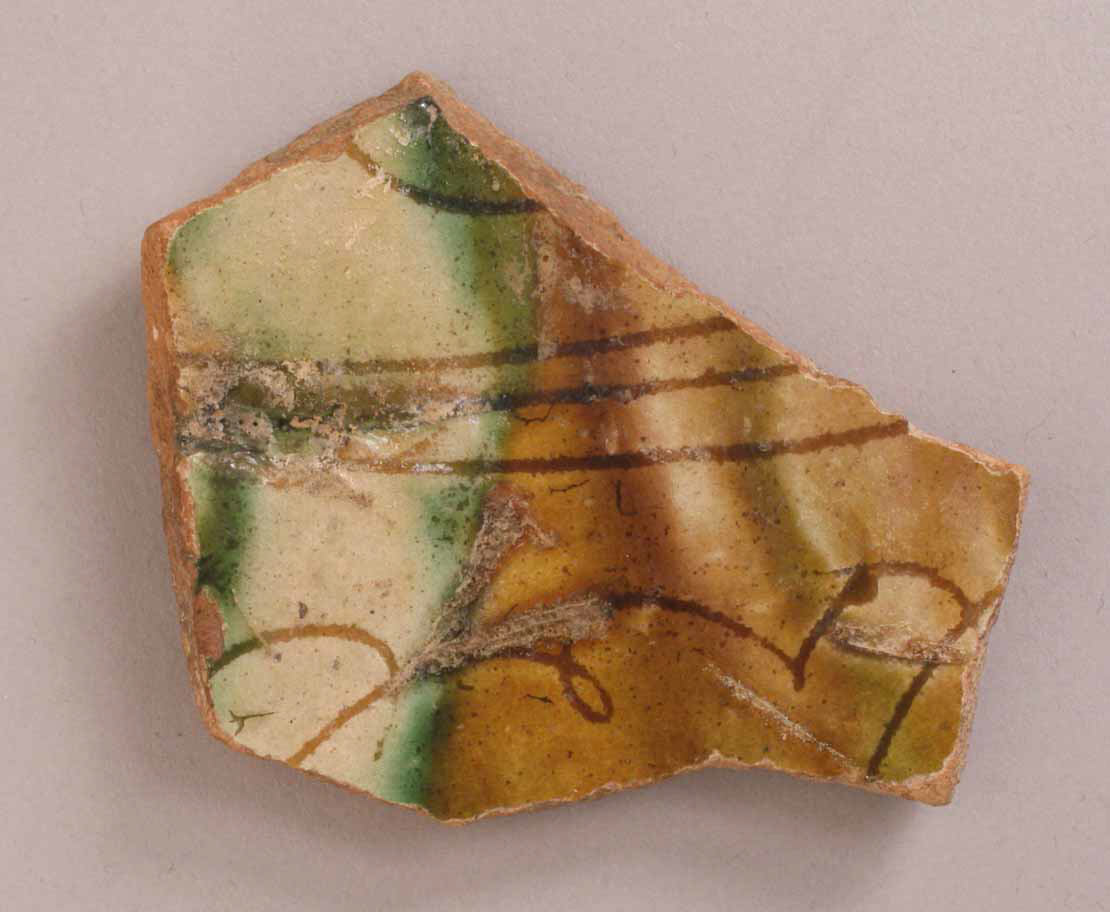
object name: fragment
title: Ceramic Fragment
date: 701-900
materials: earthenware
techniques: glazing, incising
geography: iraq